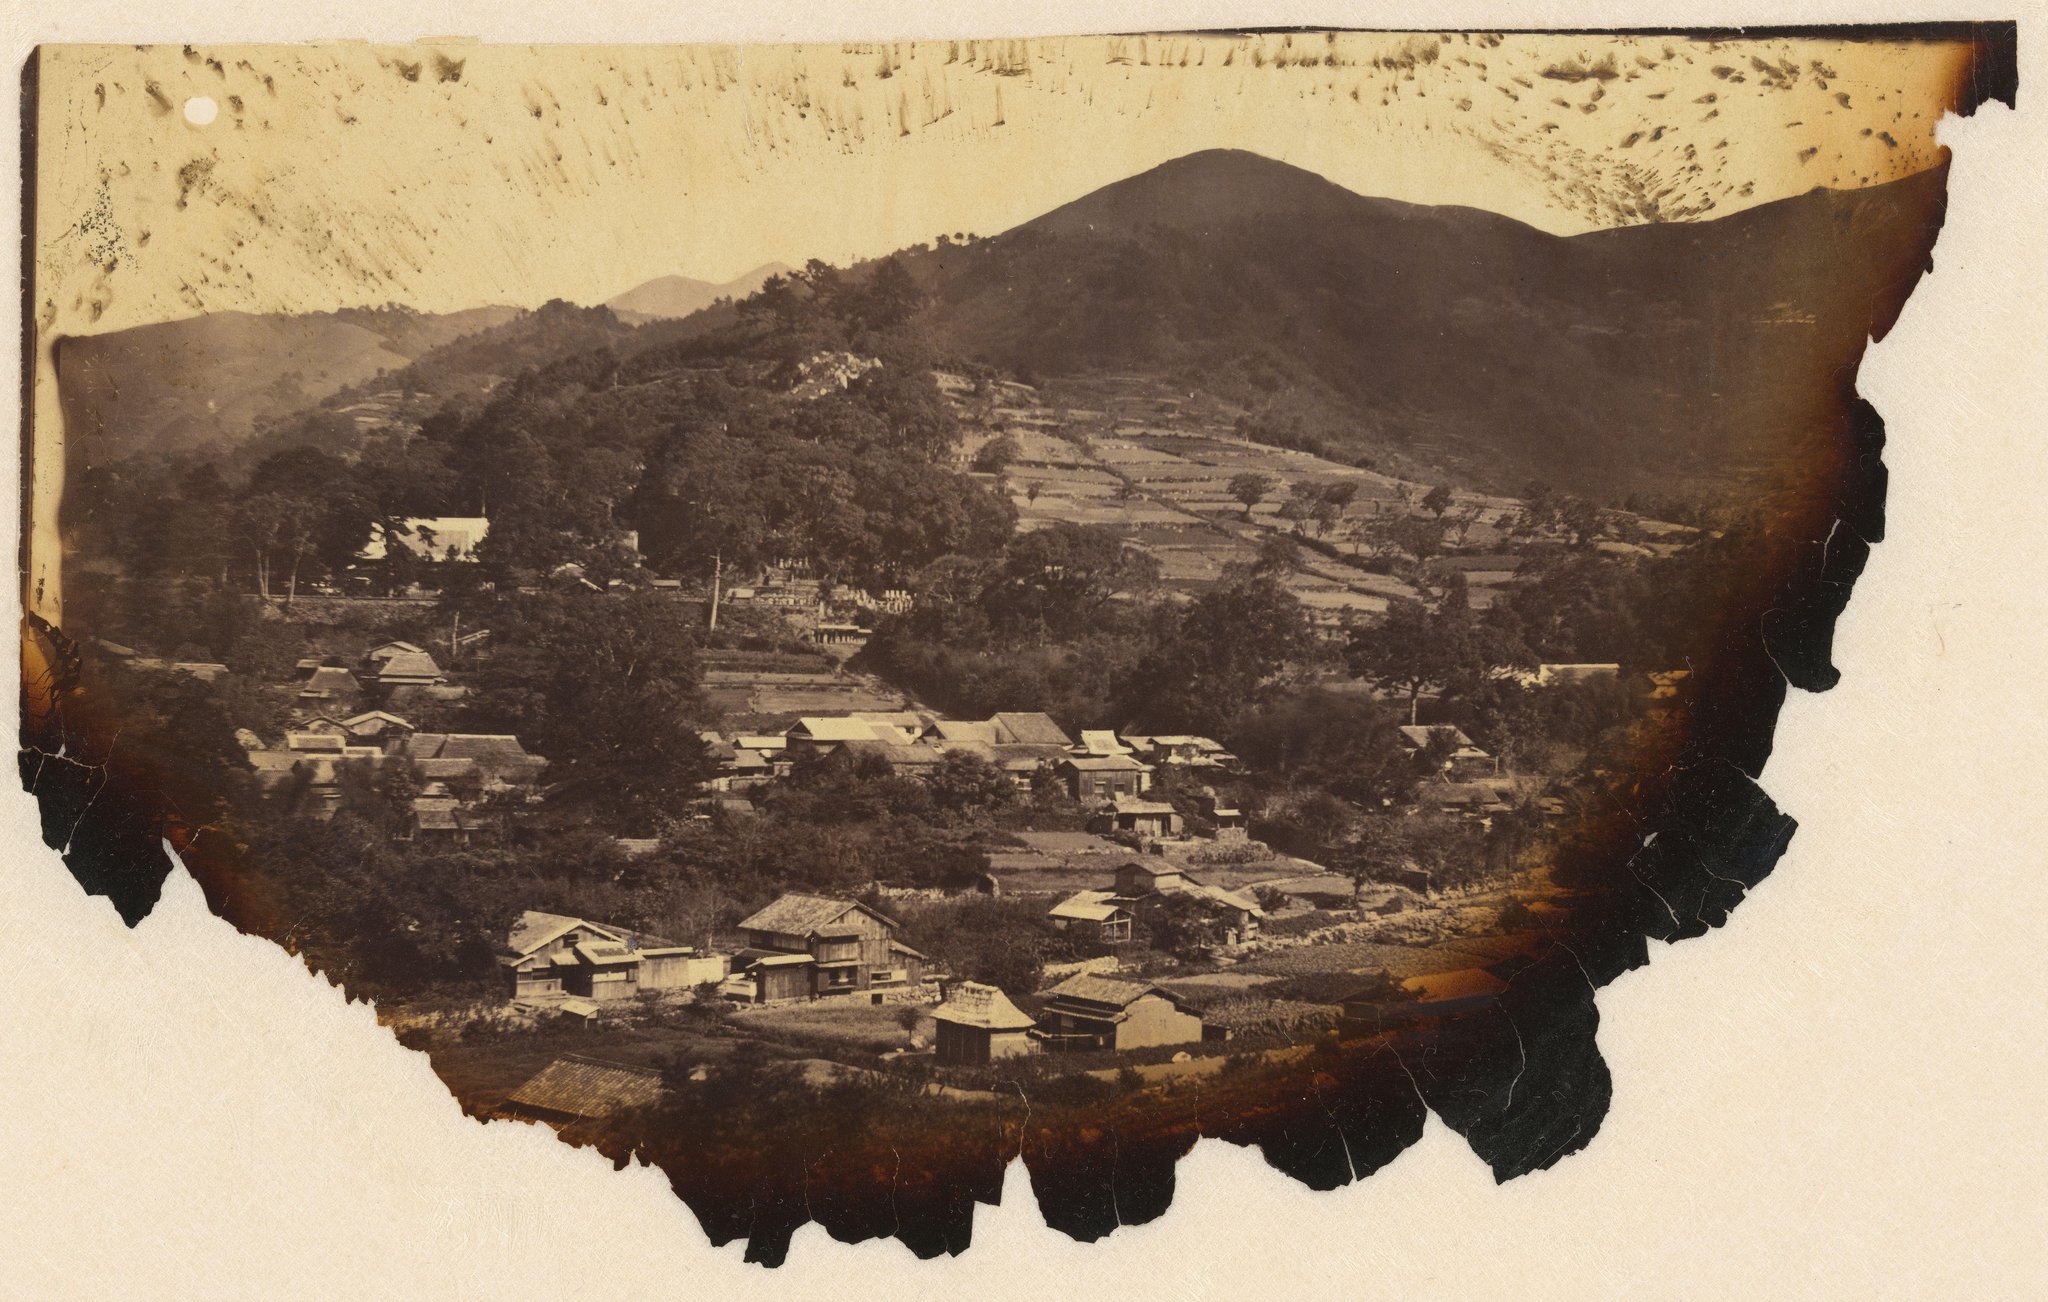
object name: photograph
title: View of Sakurababa Valley from Irabayashi Hill outside Nagasaki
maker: antoon bauduin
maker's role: amateurfotograaf, hoogleraar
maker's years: 1820-1885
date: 1862-1866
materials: paper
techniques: albumen print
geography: japan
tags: dale, valley, japan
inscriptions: number: ‘27’